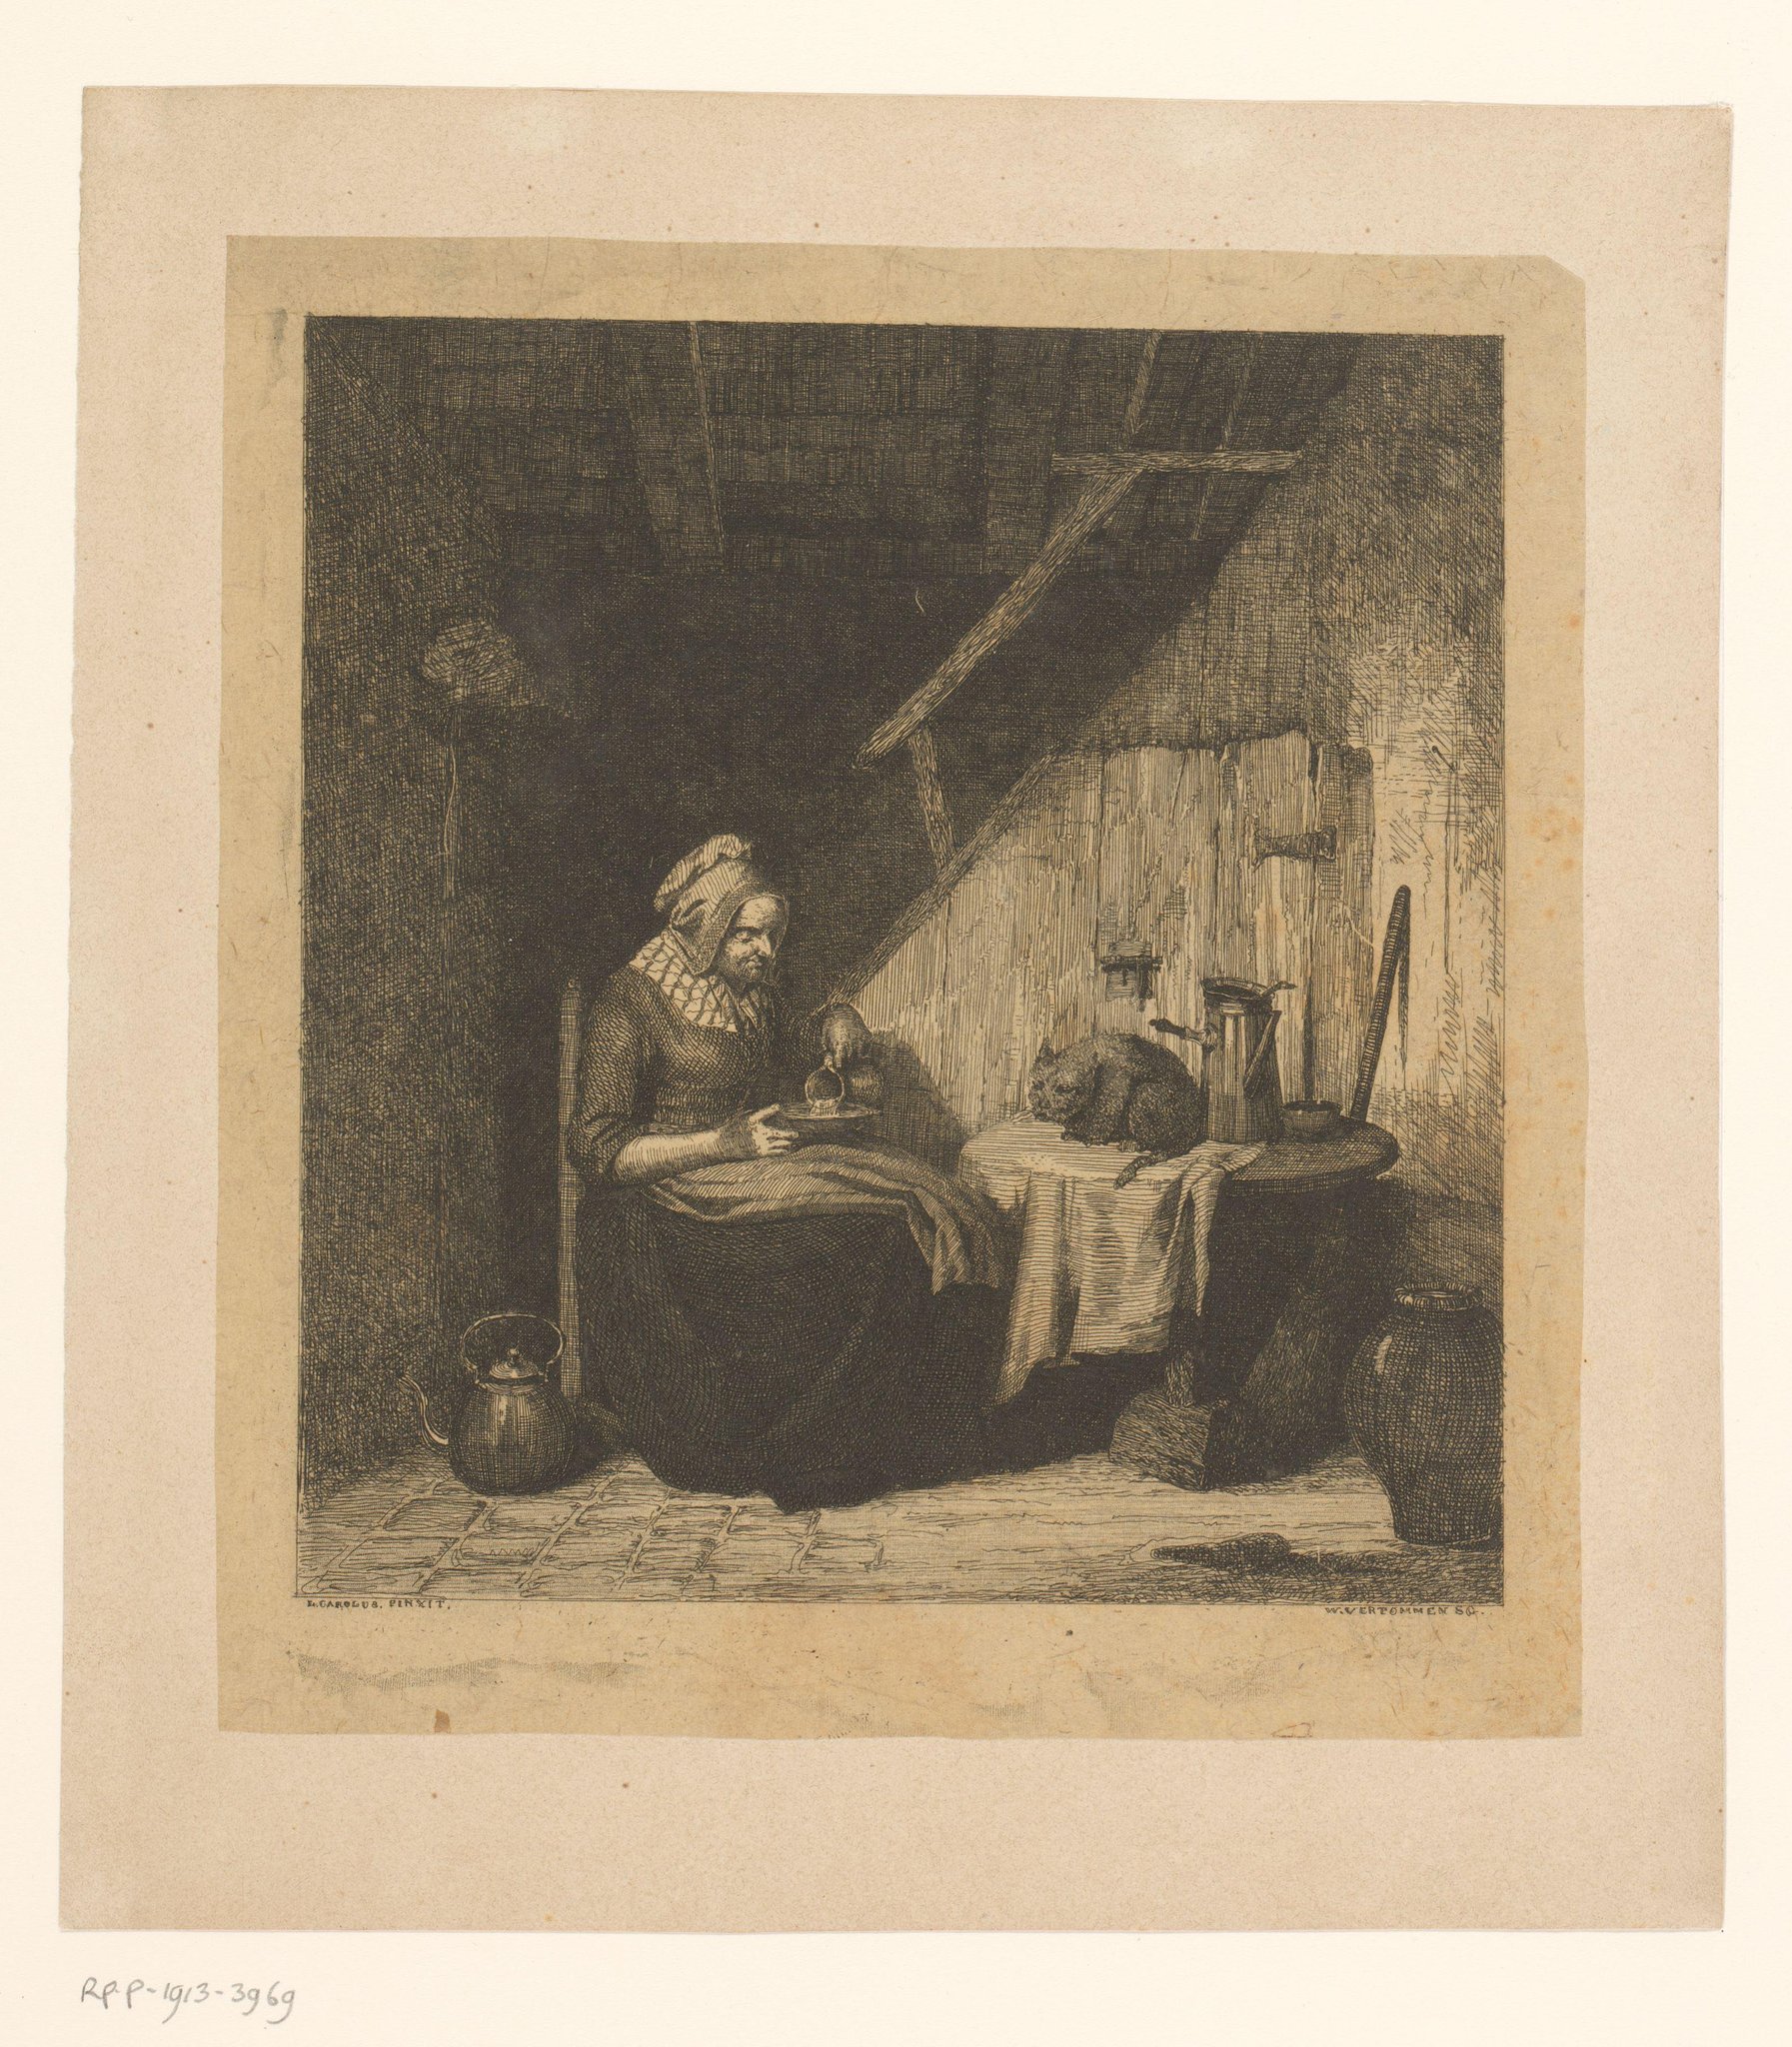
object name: print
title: Interieur met kat op tafel en een vrouw die melk inschenkt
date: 1825-1863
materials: paper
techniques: etching, roulette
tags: adult woman, pouring, cat, interior of the house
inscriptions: collector's mark: Lugt 1485, collector's mark: Lugt 2228